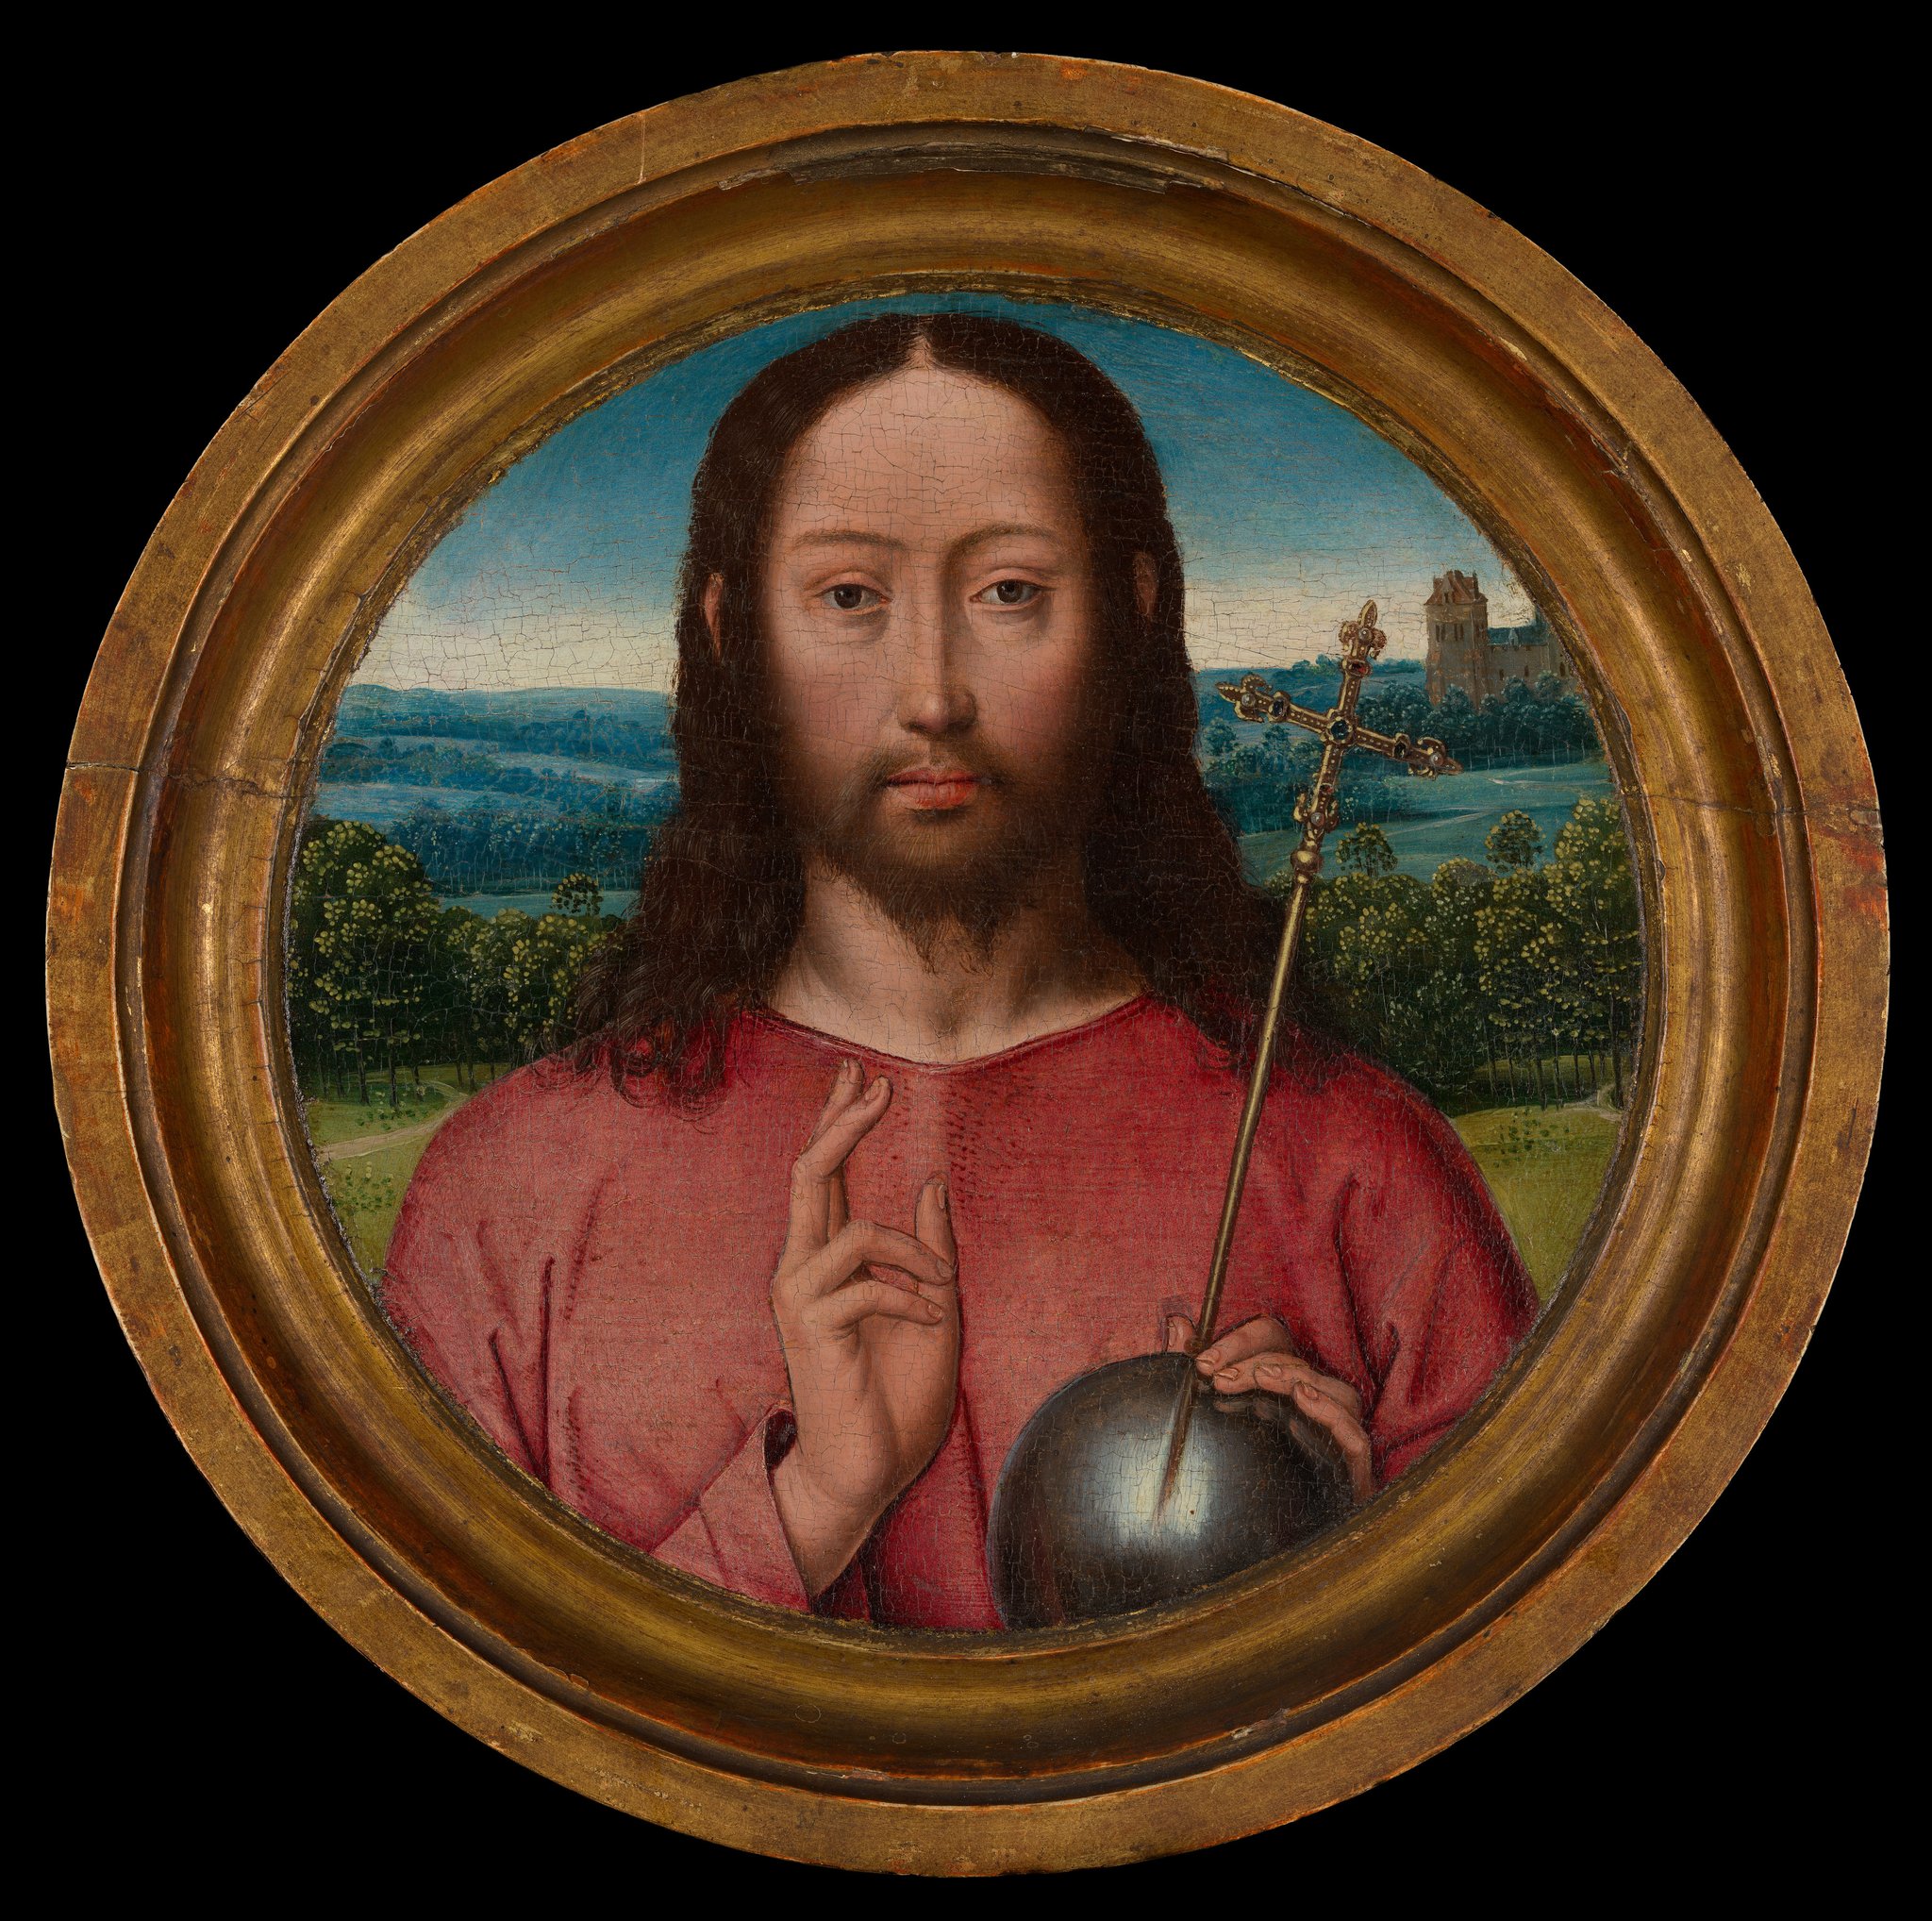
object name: painting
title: Salvator Mundi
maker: hans memling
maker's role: artist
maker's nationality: netherlandish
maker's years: 1465-1494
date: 1480-1485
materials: oil, wood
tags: christ,cross